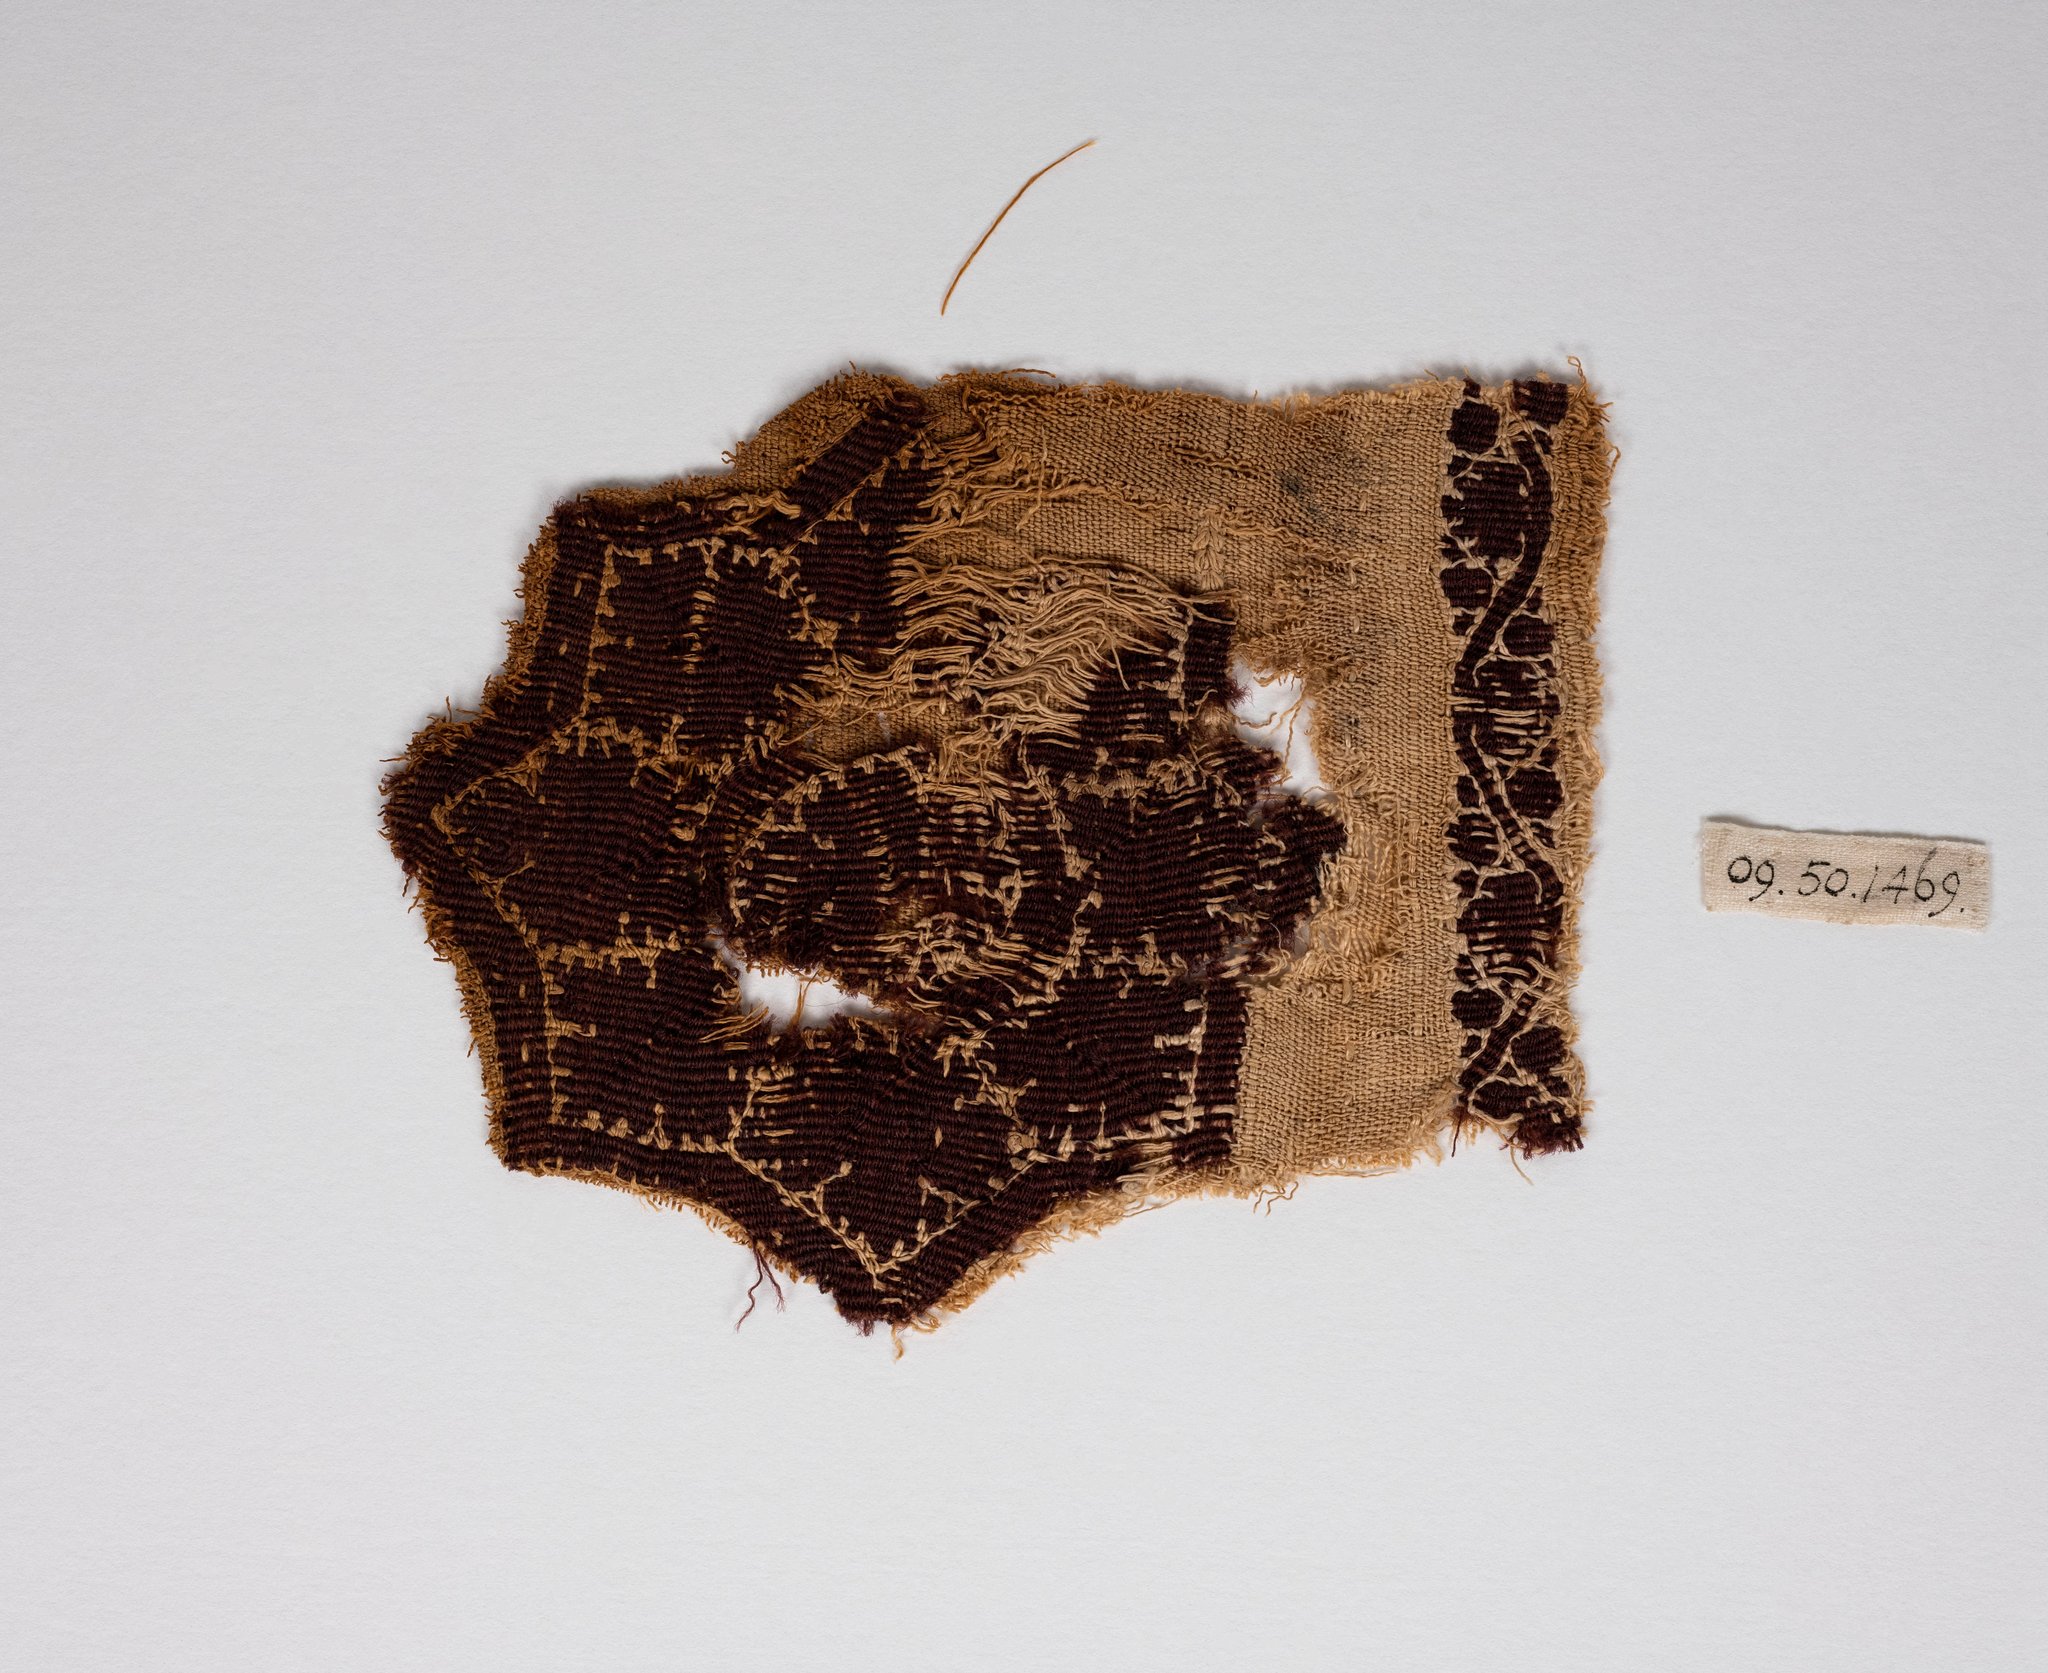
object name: textile fragment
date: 201-400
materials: linen, wool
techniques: weave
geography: egypt